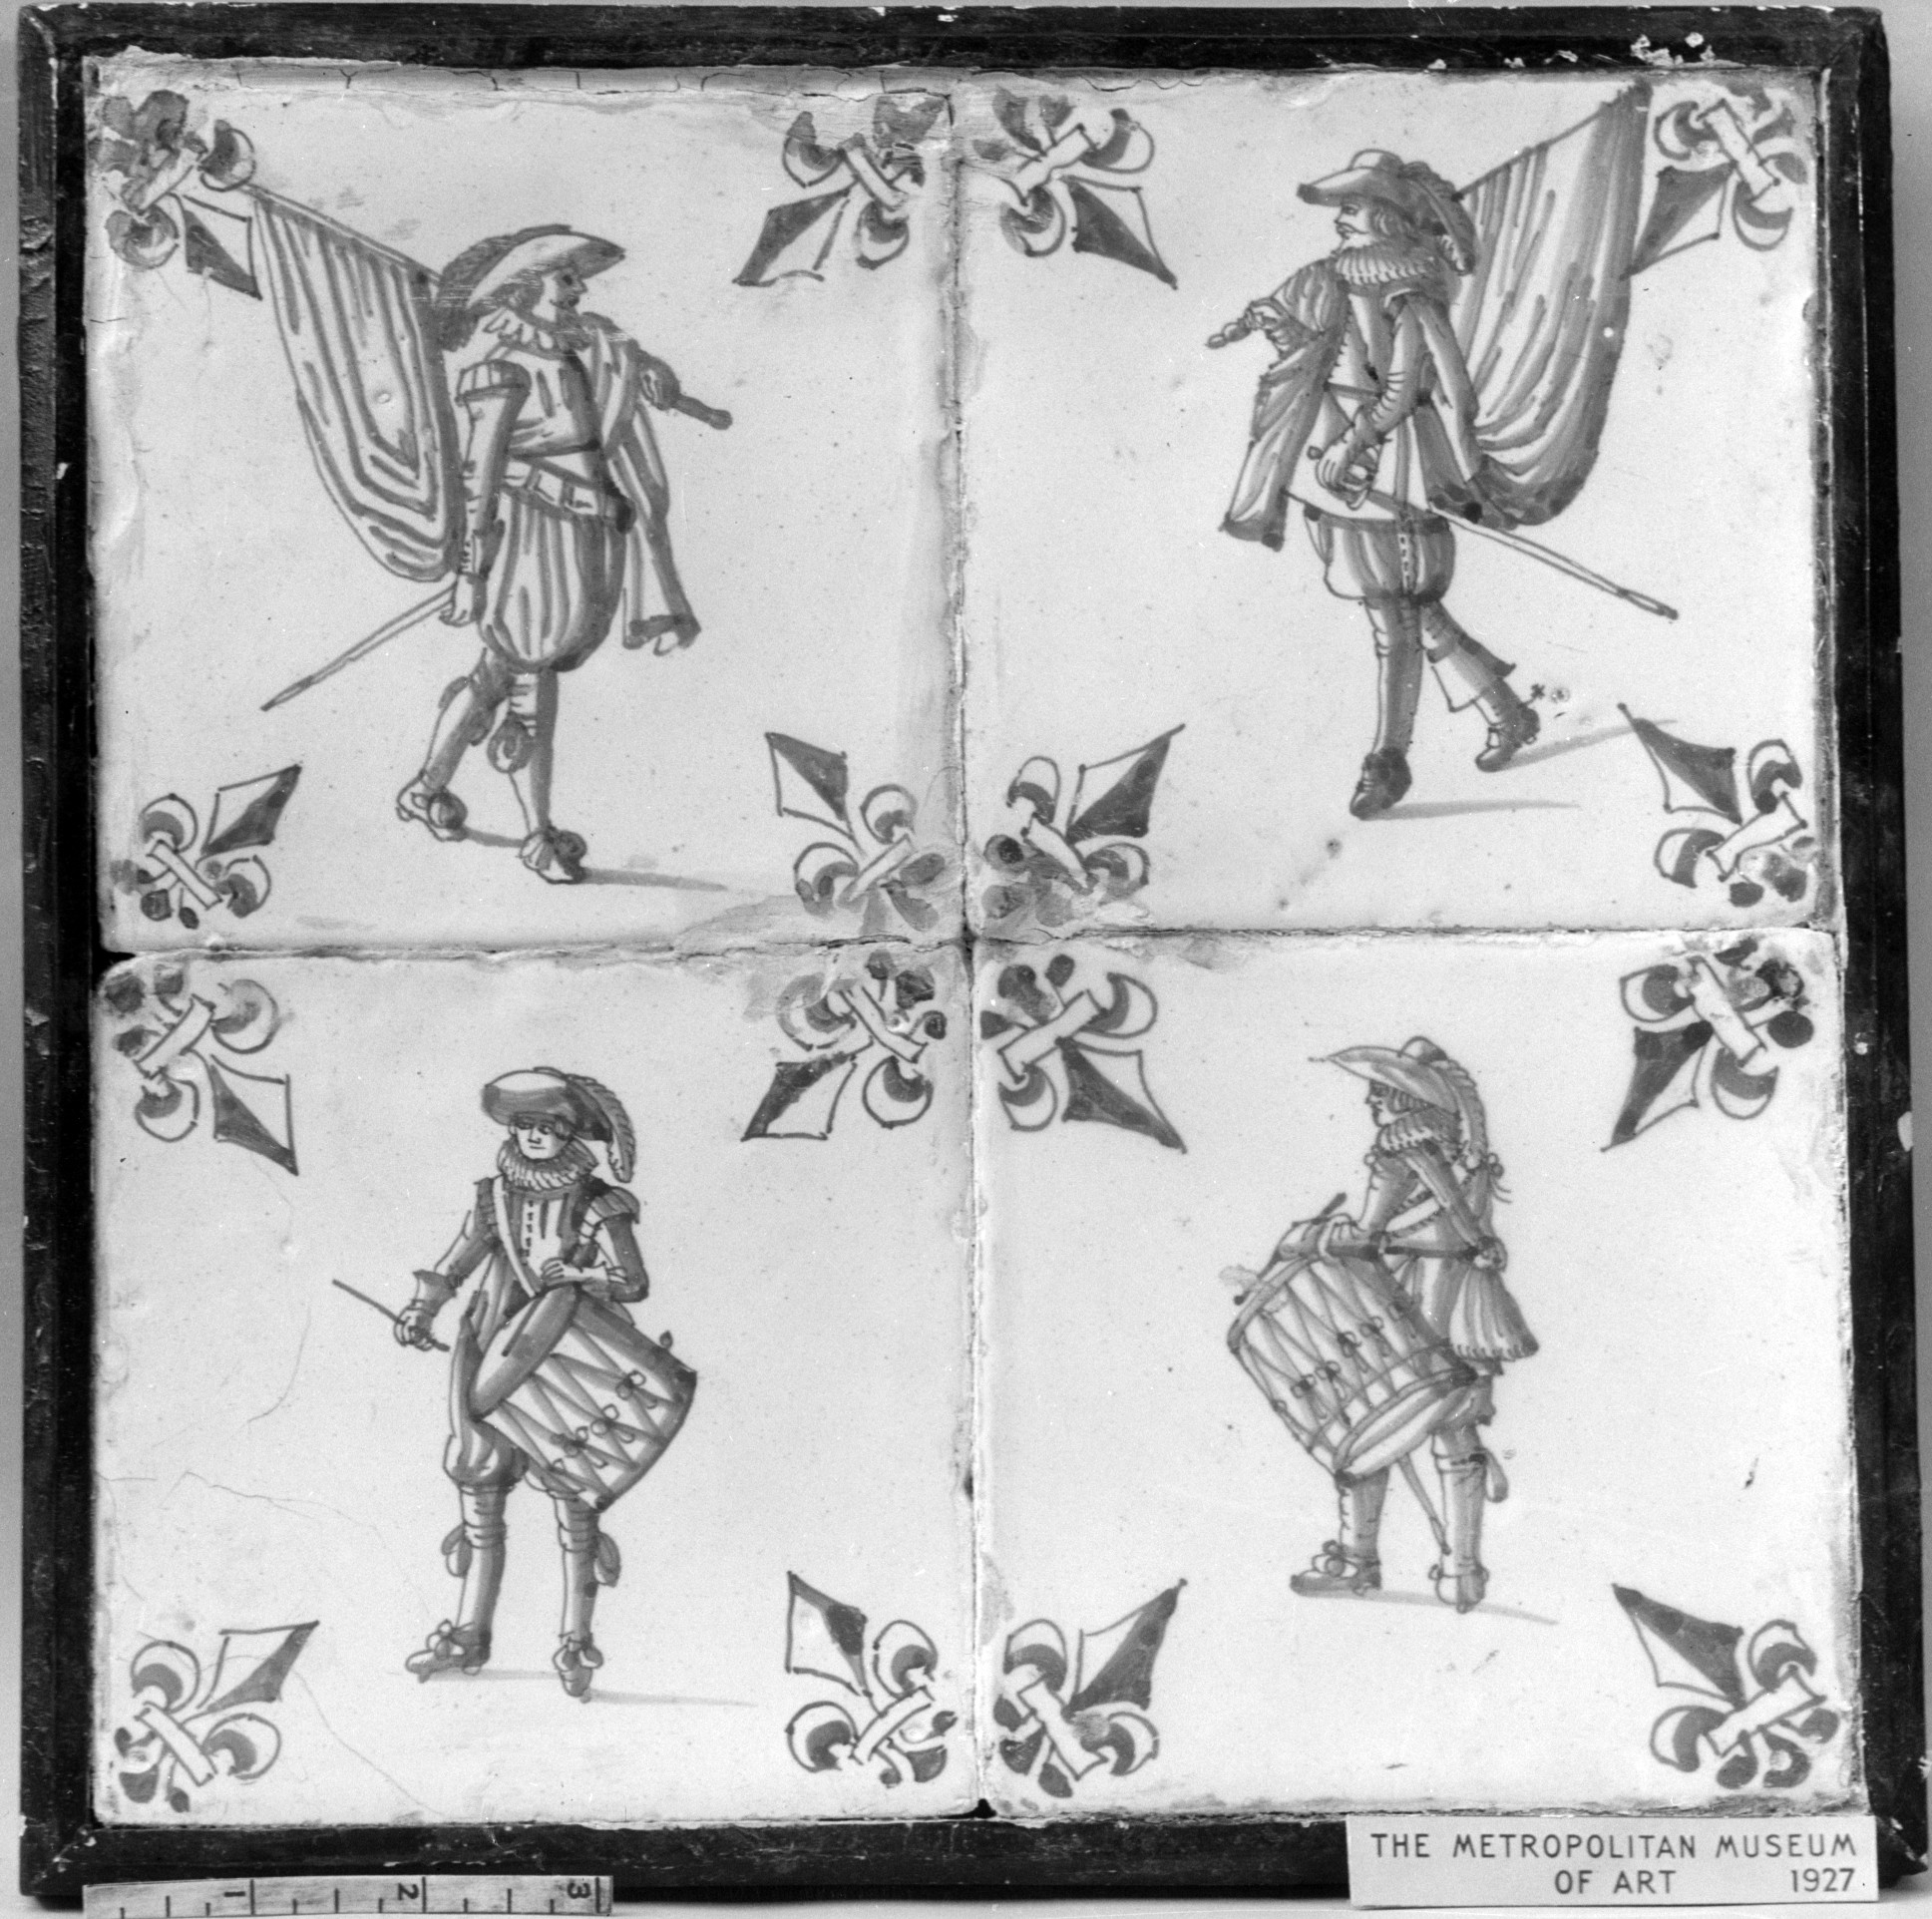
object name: tile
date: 1701-1900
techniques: glazing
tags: musical instruments,swords,men,flags